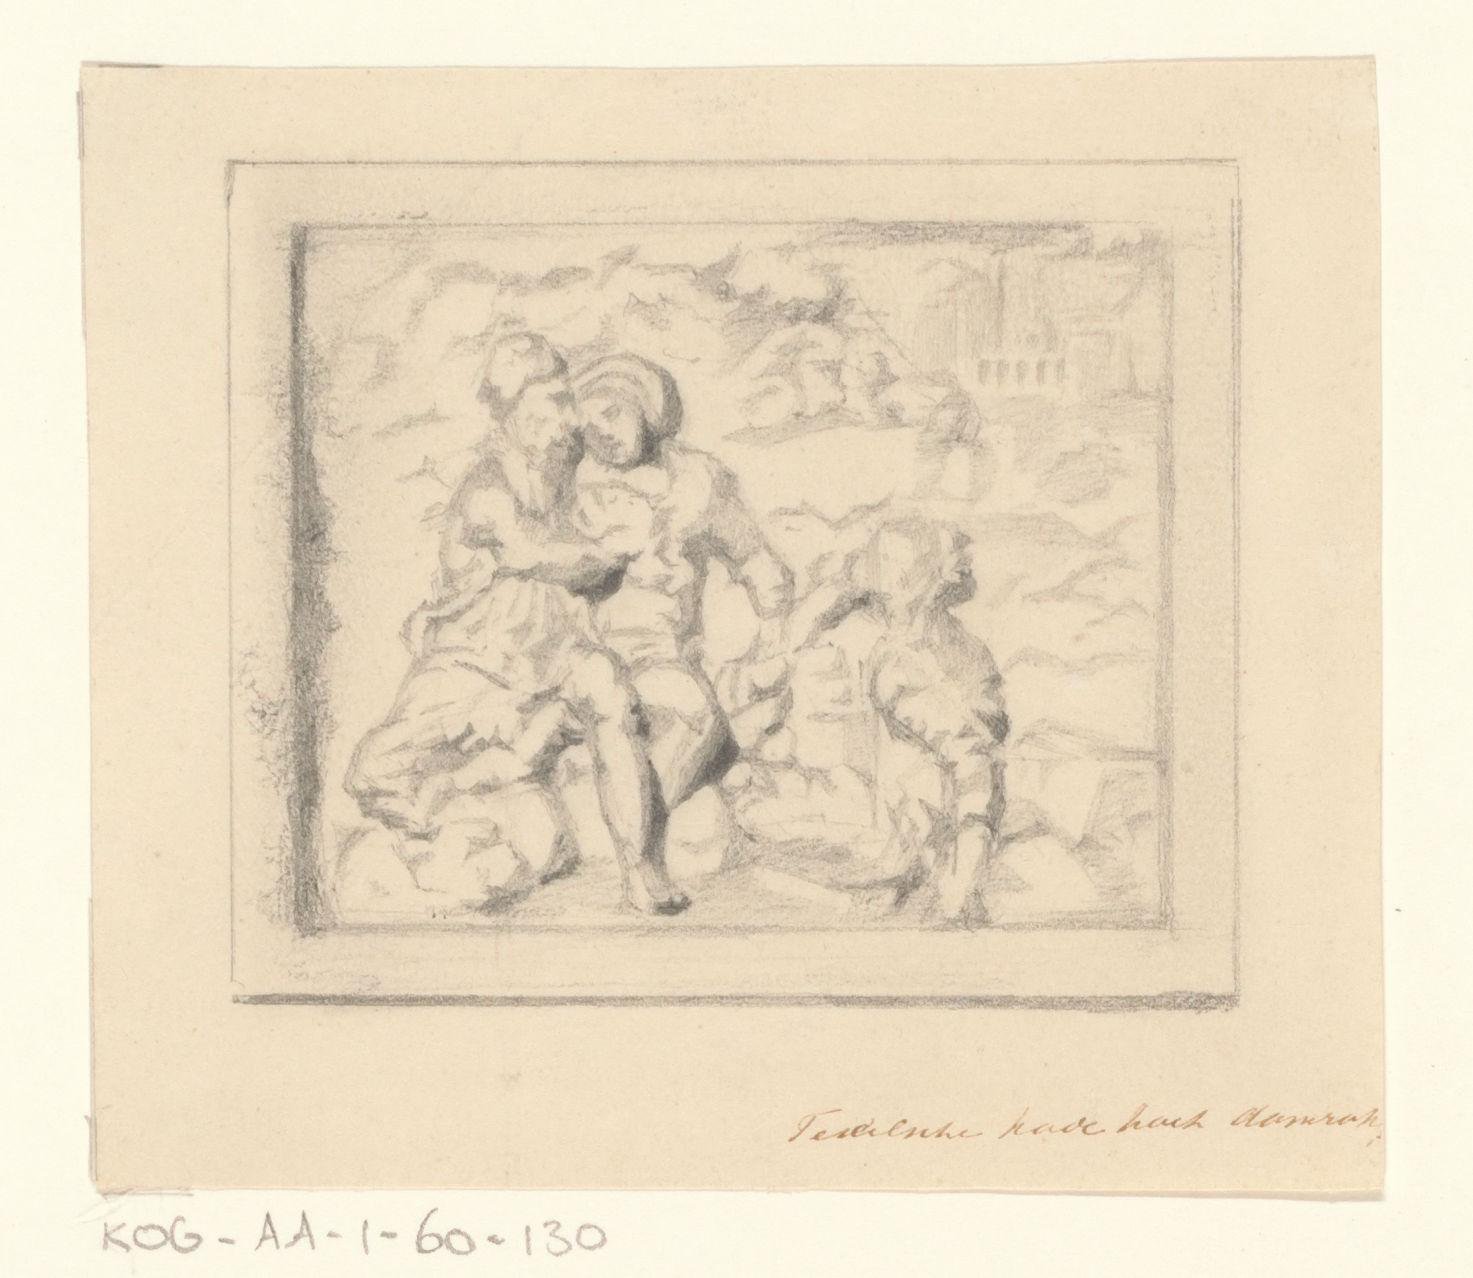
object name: drawing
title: Gevelsteen op de Texelsche Kade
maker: Anonymous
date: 1800-1899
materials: paper, pencil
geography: amsterdam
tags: stone tablet in façade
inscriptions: inscription: ‘Texelsche kade hoek damrak’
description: Onderwerpsrubriek binnen de Atlas Amsterdam: Beeldhouwkunst - Gevelstenen.